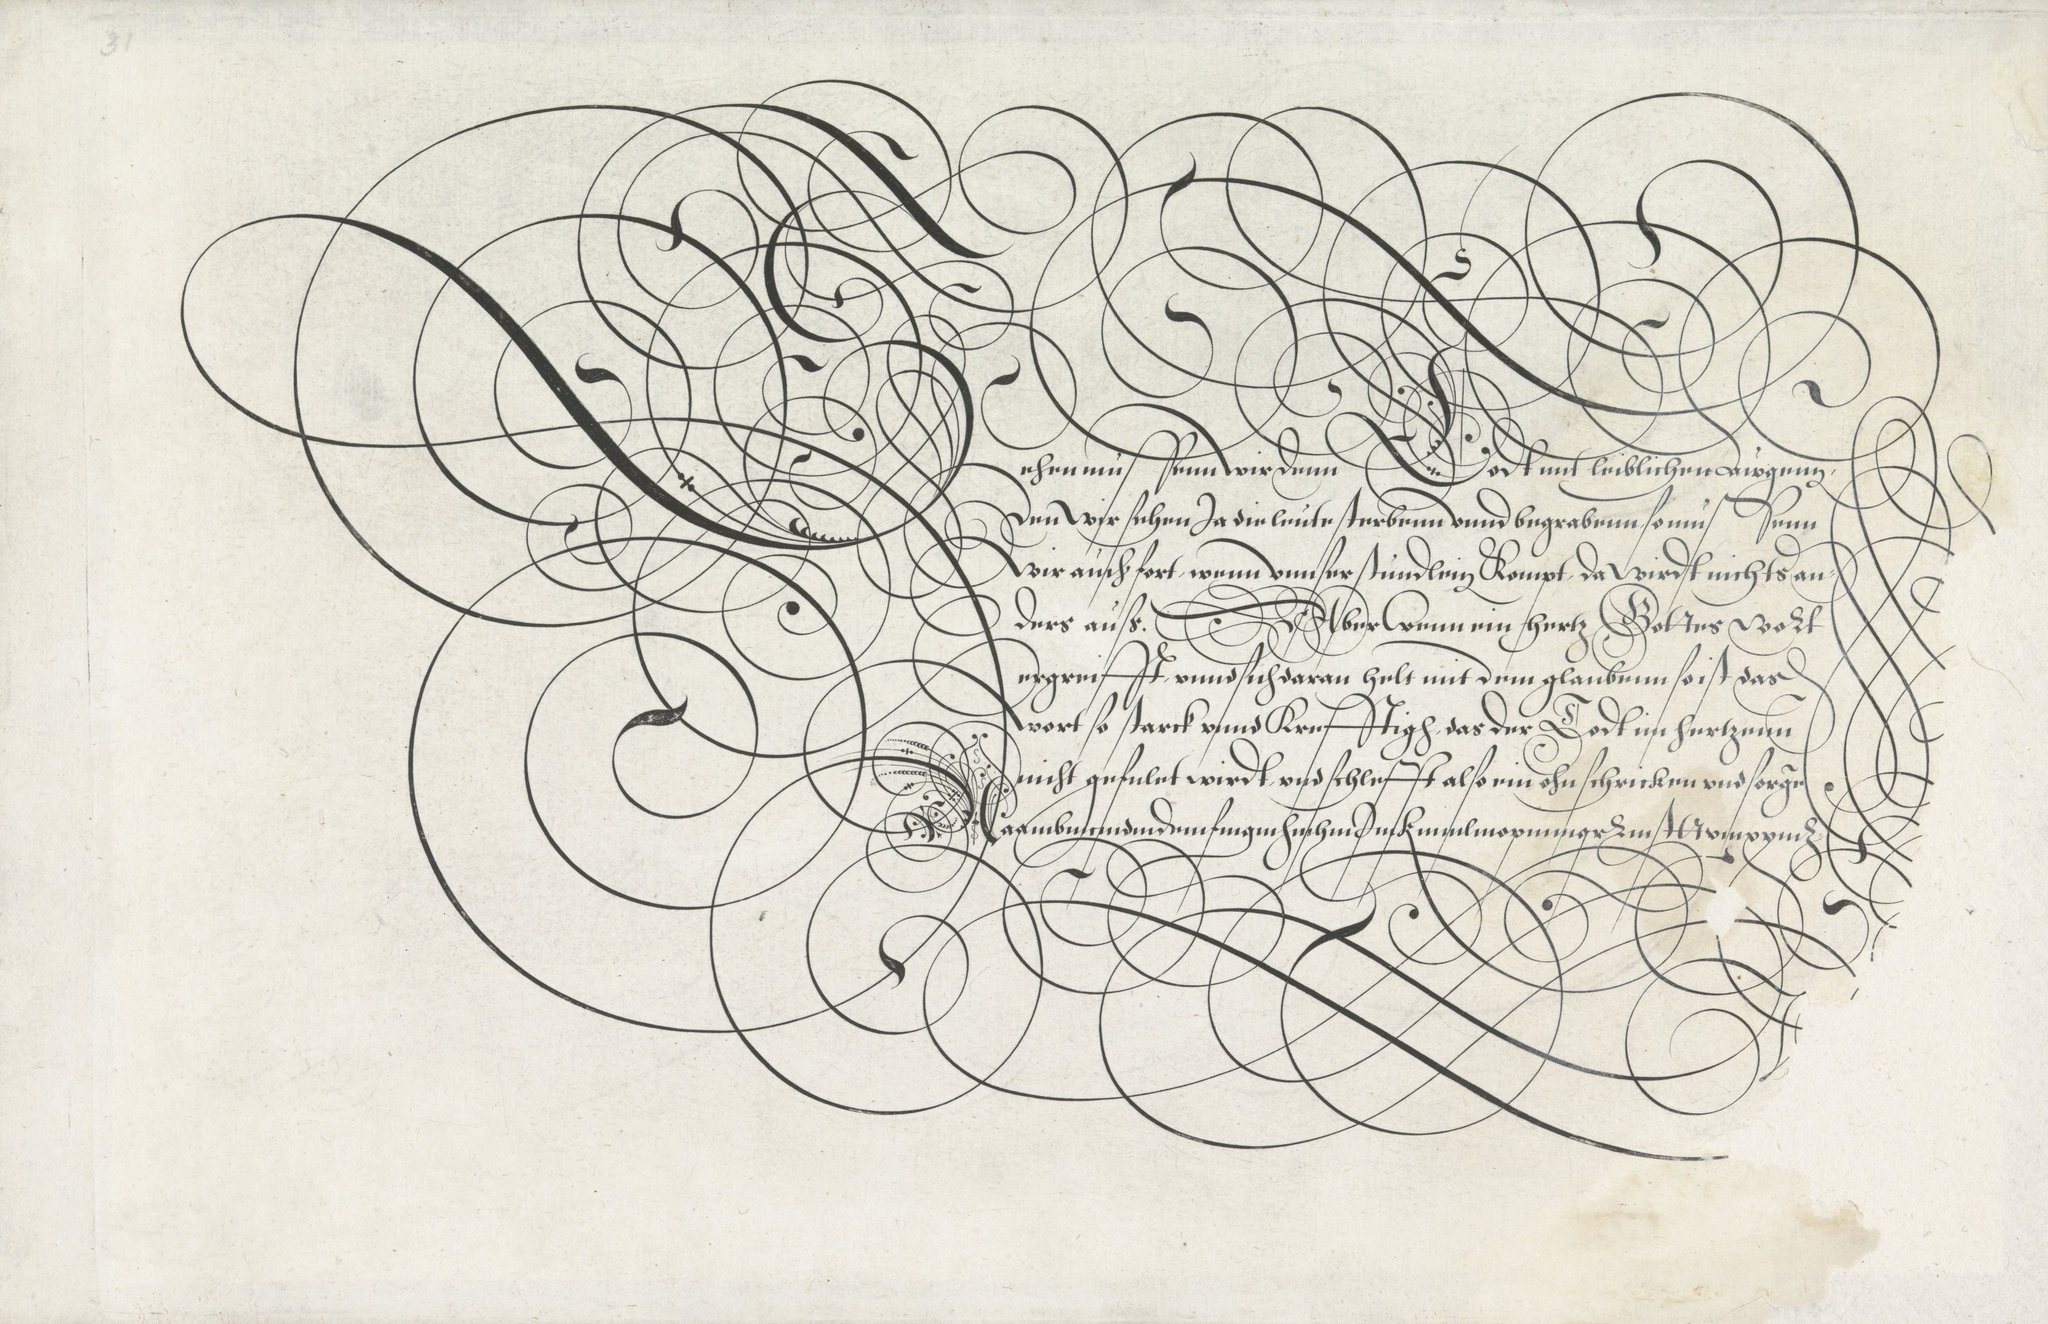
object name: ornament print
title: Spieghel der schrijfkonste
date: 1605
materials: paper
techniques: engraving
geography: haarlem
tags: calligraphy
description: Schrijfvoorbeeld met initiaal S en acht regels tekst in het Duits: Sehen ... Het voorbeeld eindigt met een onderkastalfabet in de betreffende hand. De tekst is omlijst door krulwerk. De prent maakt deel uit van een album.